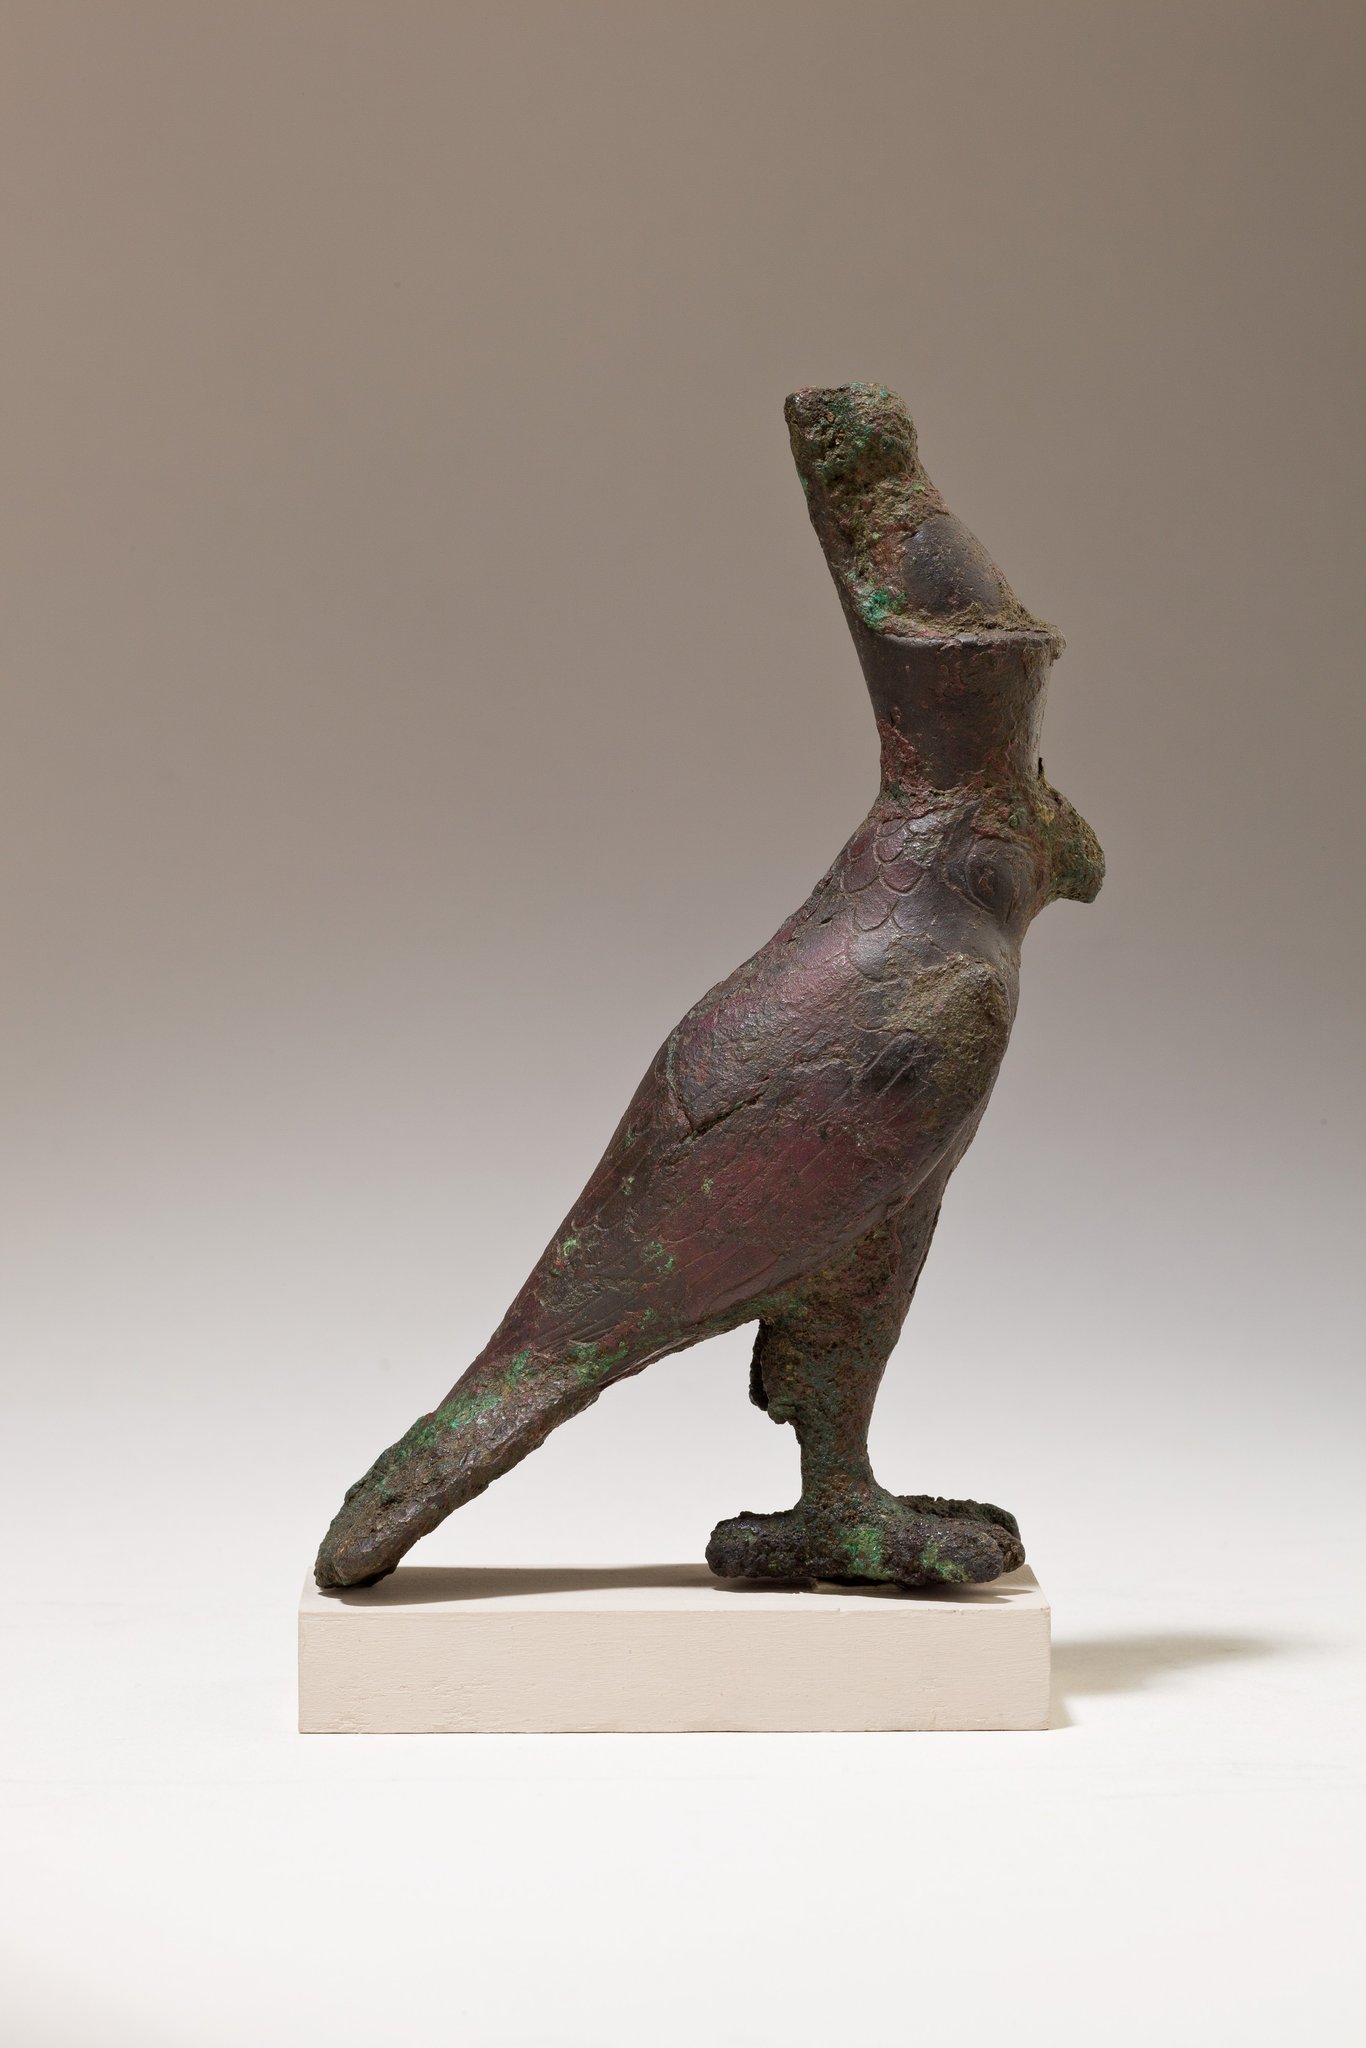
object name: figurine, falcon, double crown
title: Falcon in double crown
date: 664-630 BCE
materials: metal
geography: egypt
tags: falcons,horus